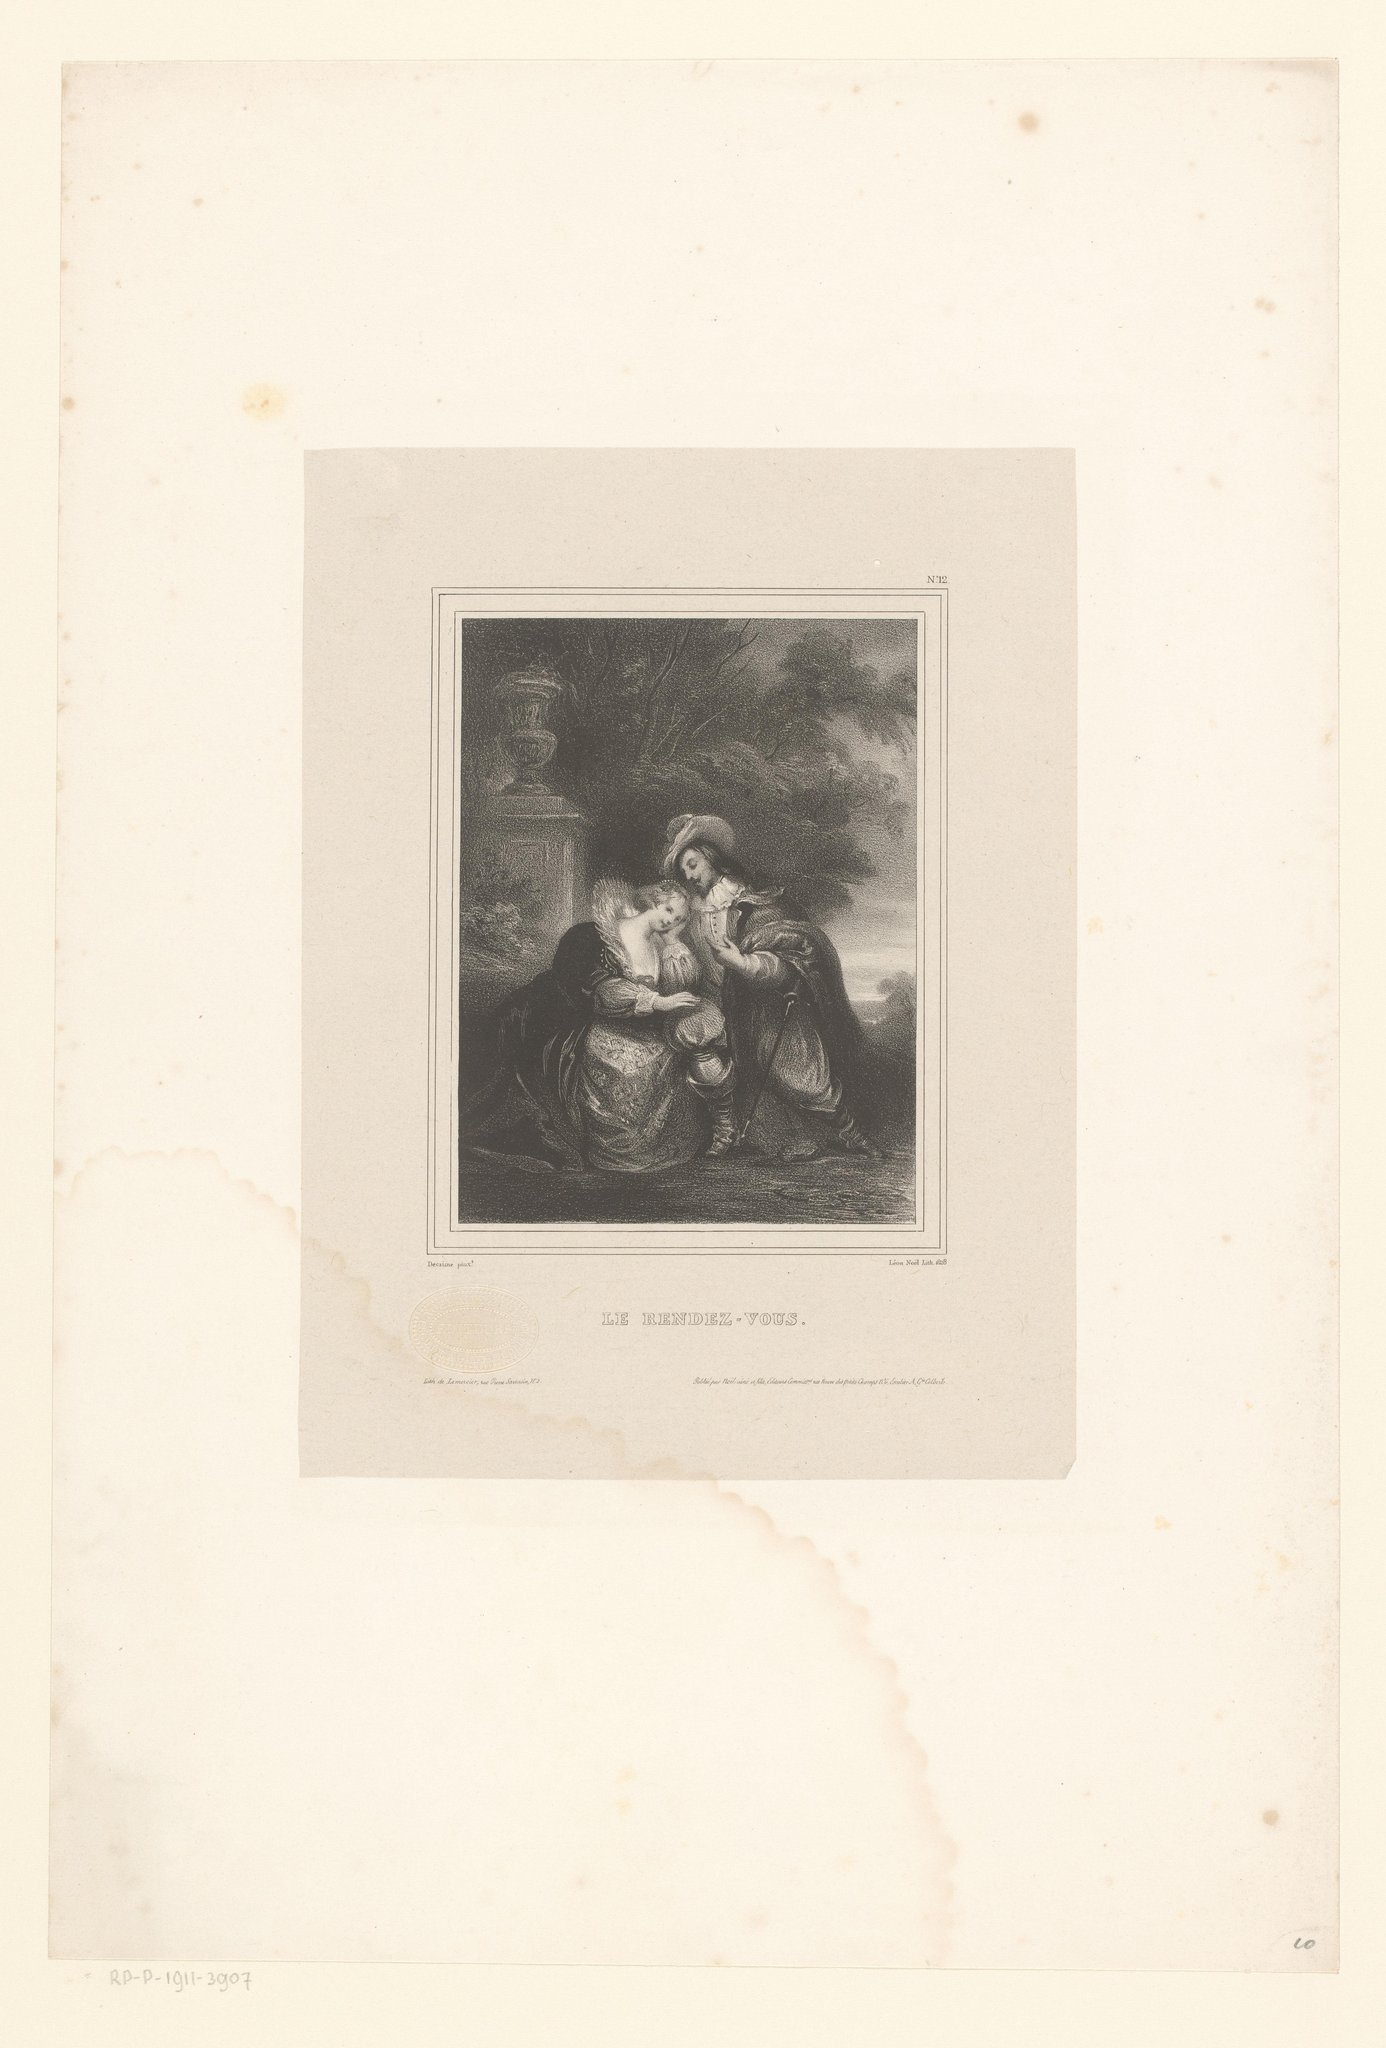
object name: print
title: Afspraakje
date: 1828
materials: paper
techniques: lithograph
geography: paris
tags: fashion, clothing, head-gear, hacking and thrusting weapons: sword, lovers' meeting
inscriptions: check stamp: Lugt 4944, collector's mark: Lugt 2228